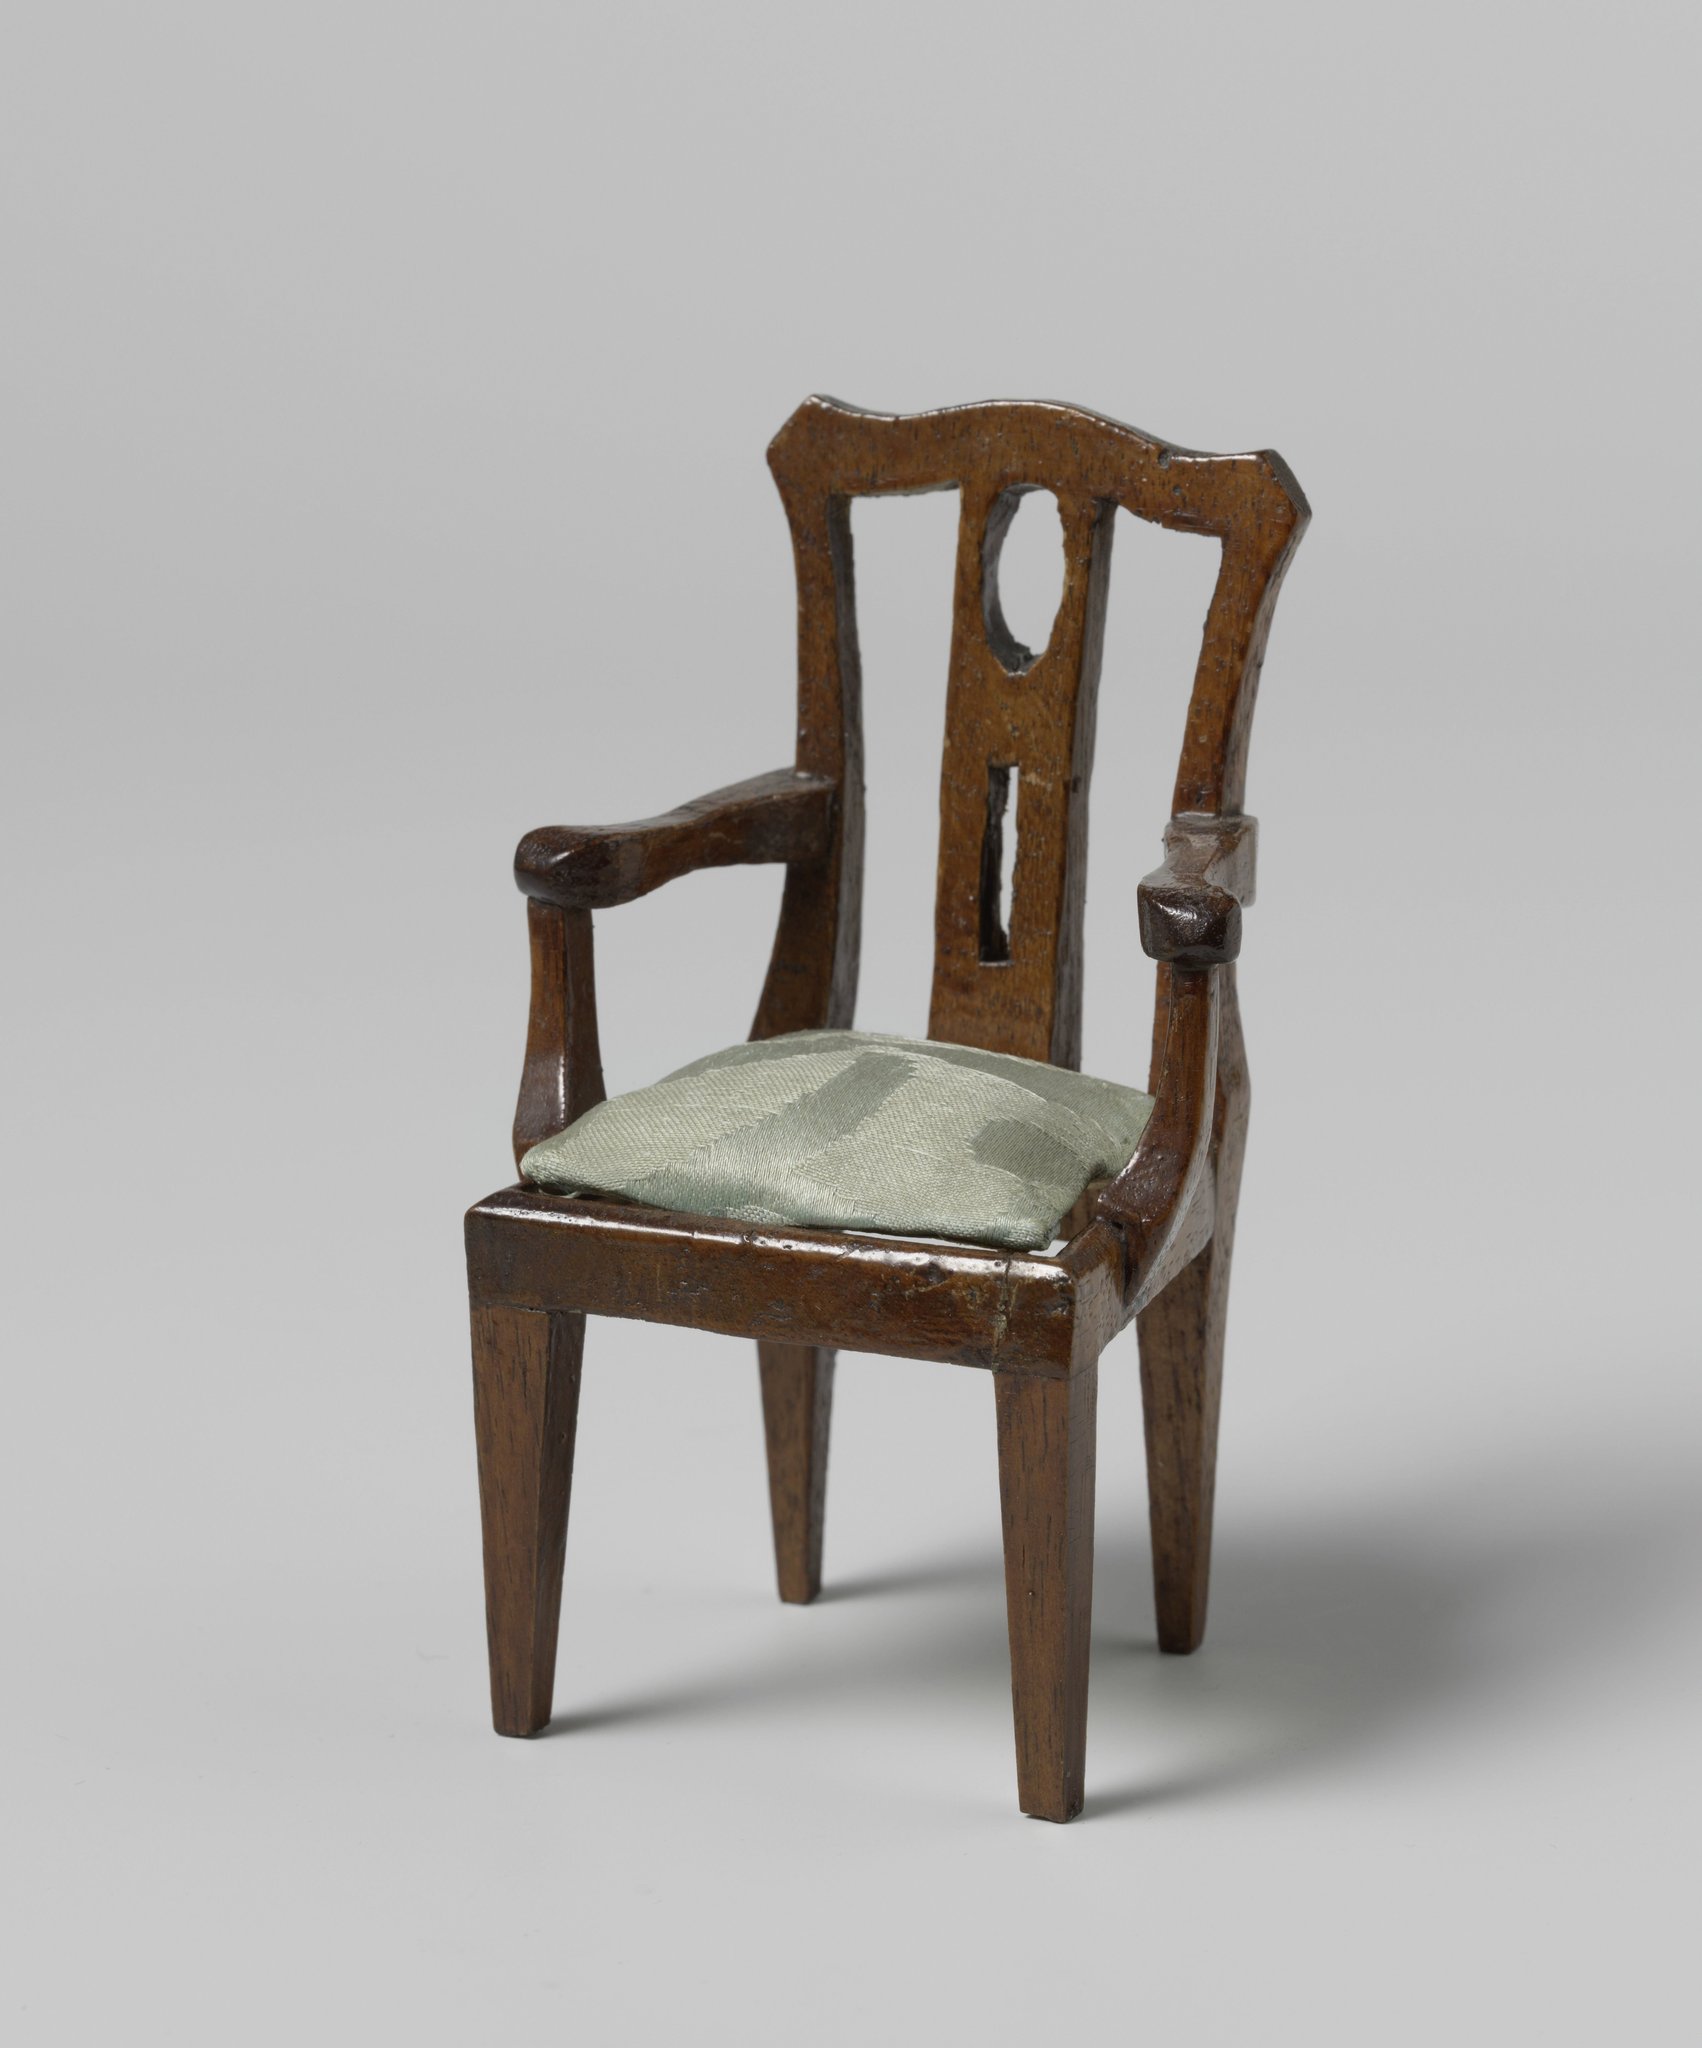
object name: chair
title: Armstoel met blauwe bekleding en rechte rug met opengewerkte middenstijl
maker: Anonymous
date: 1775-1800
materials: cardboard, wood, paper, silk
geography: amsterdam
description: Armstoel van mahoniehout met een rechte rug, rechte opengewerkte middenstijl en strakke taps toelopende poten. De losse zitting is bekleed met blauwe zijden damast.